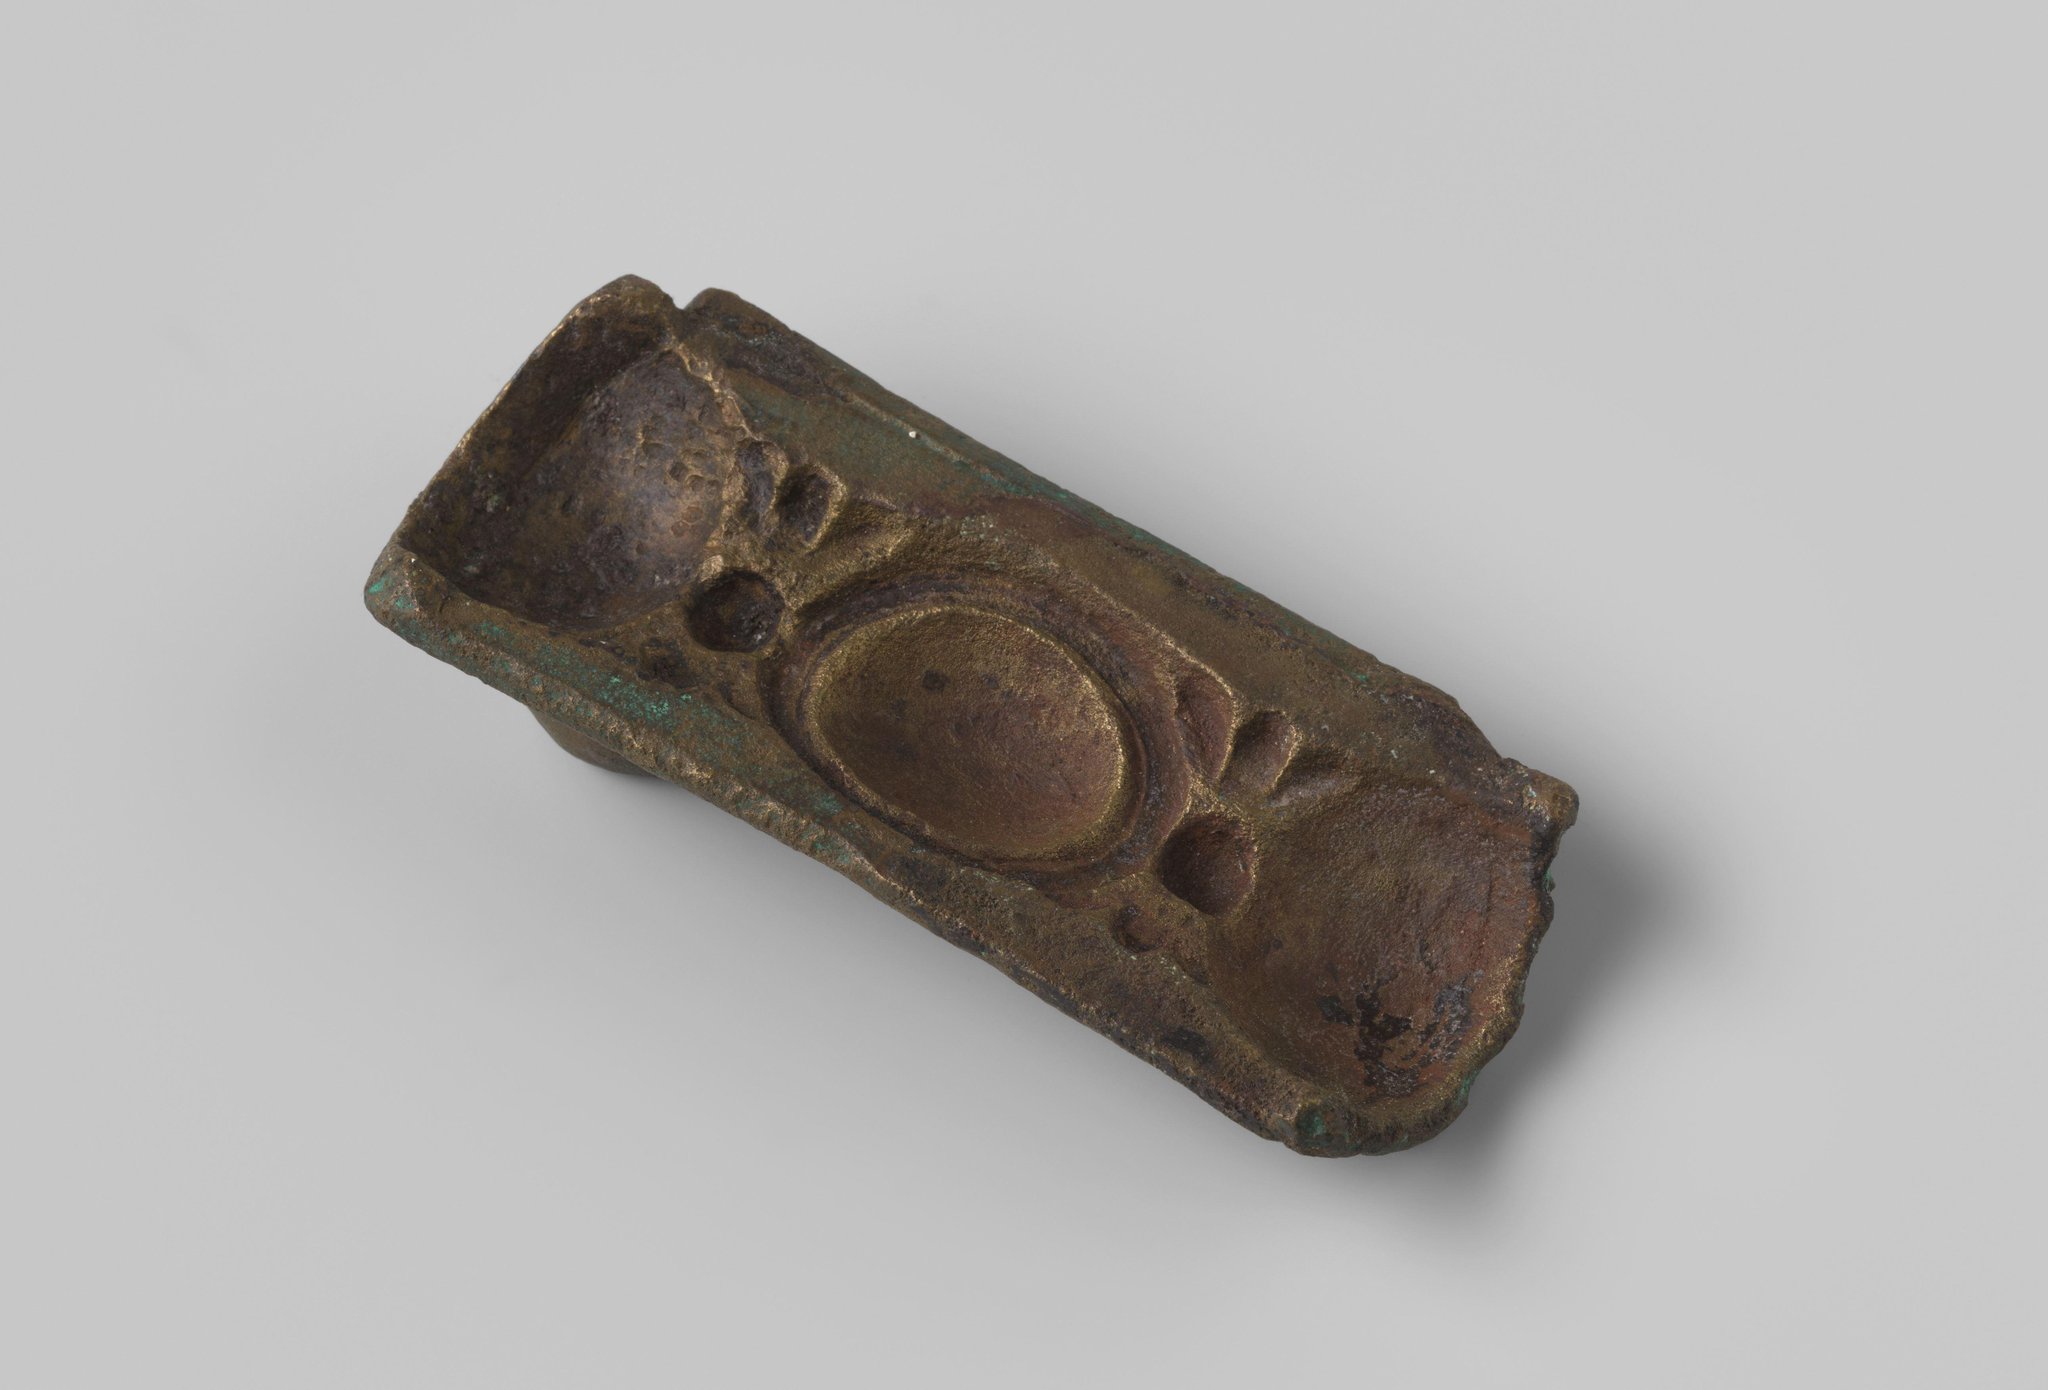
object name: mould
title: Mal uit het wrak van de Oost-Indiëvaarder Hollandia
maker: Anonymous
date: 1700-1743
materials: copper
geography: netherlands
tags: verenigde oostindische compagnie, hollandia (schip), annet